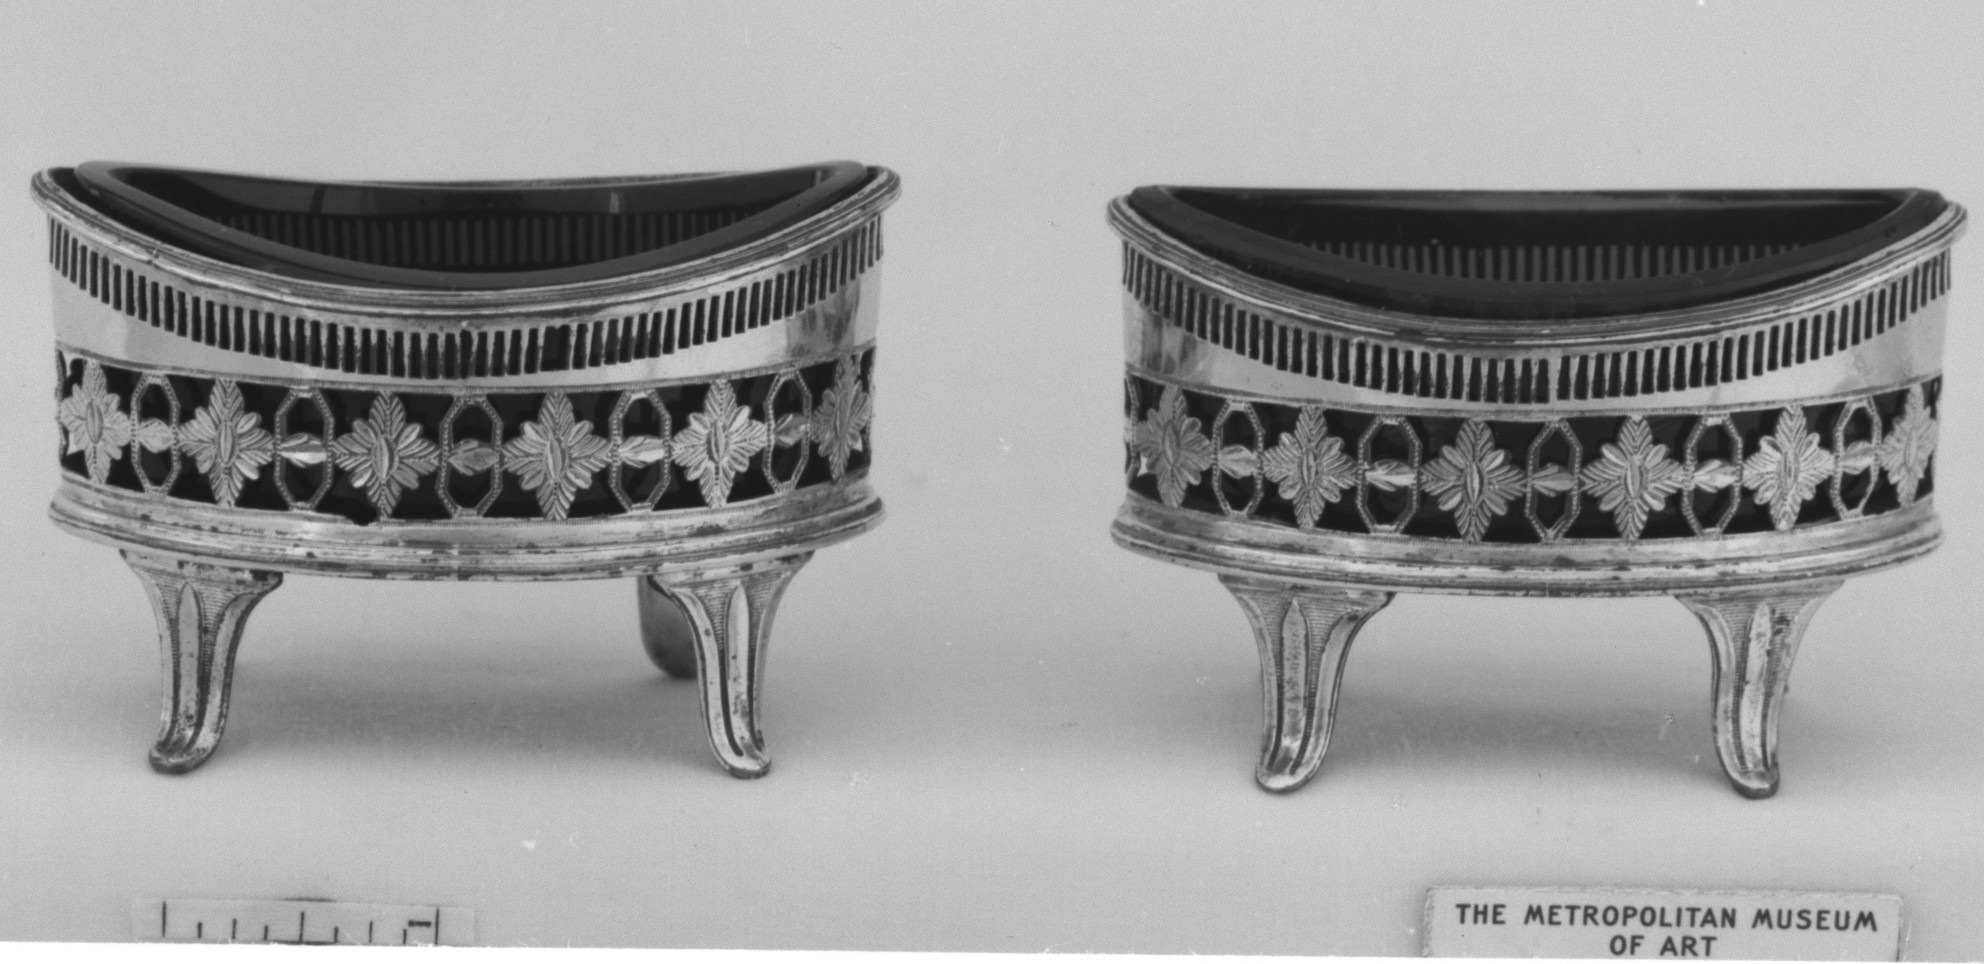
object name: saltcellar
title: Saltcellar (one of a pair)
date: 1785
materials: glass, metal